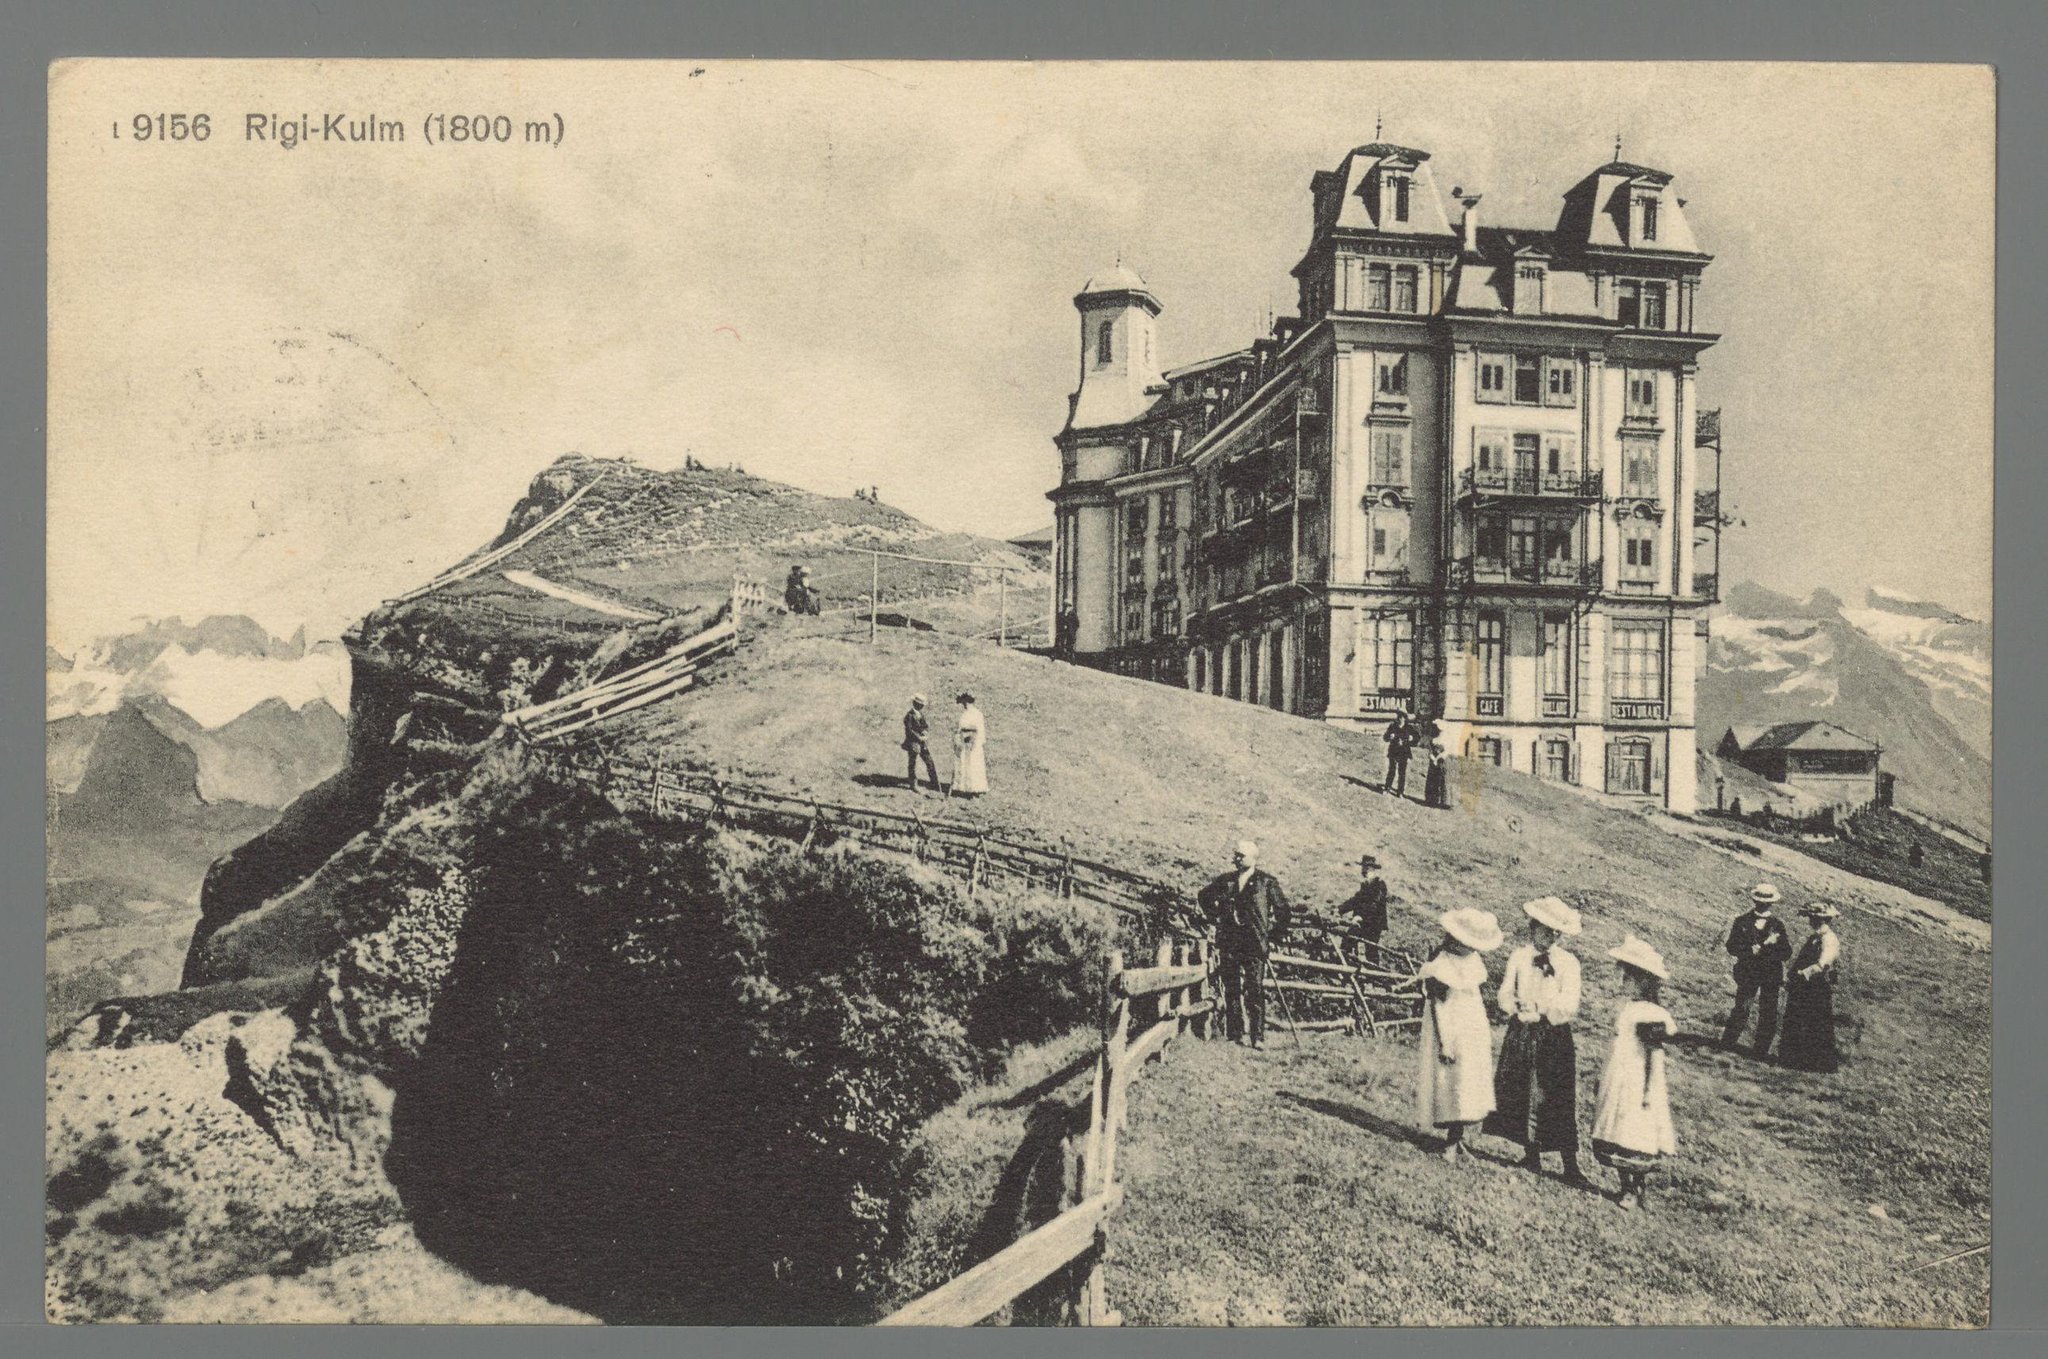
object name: photomechanical print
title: Rigi-Kulm (1800 m)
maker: Anonymous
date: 1905-1912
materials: cardboard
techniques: photograph, writing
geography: zurich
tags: mountain-range, snow peaks (+ landscape with figures, staffage), hotel, hostelry, inn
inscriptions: postage stamp